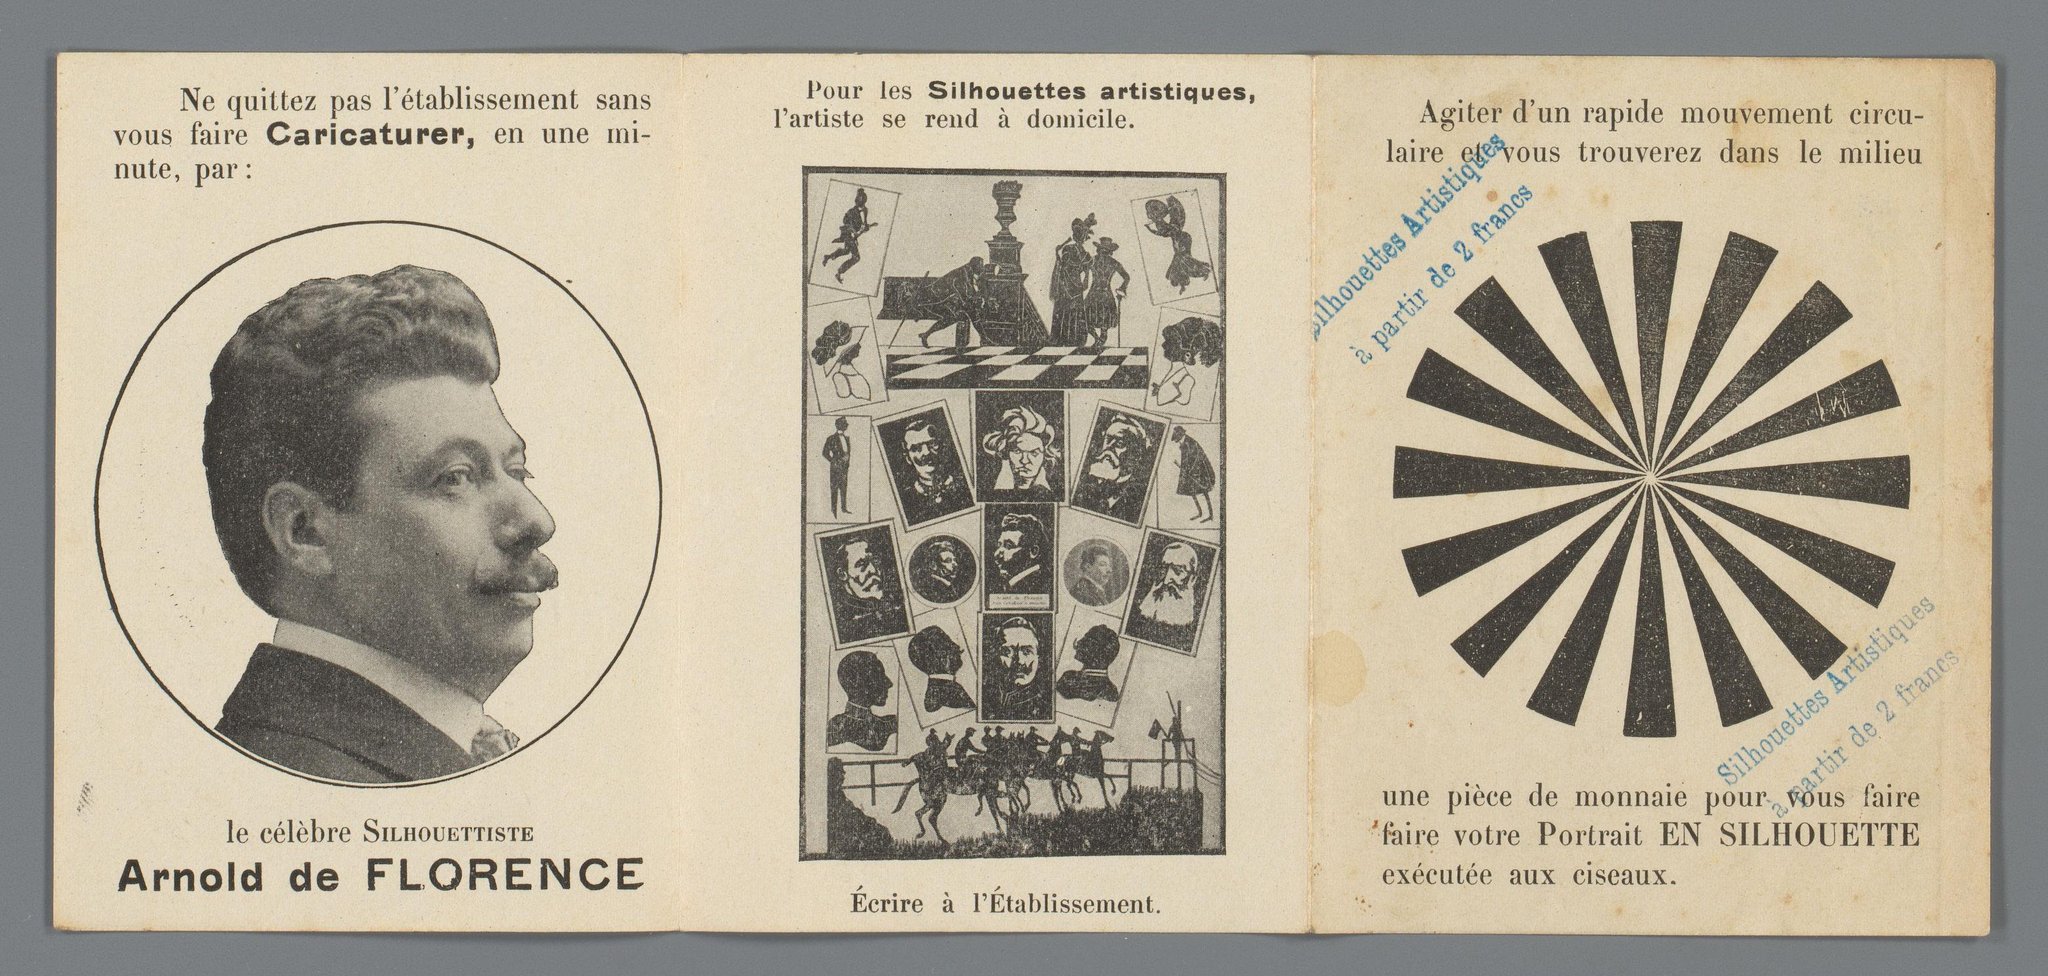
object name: photomechanical print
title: Reclamefolder voor 'le célèbre Silhouettiste Arnold de Florence'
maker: Anonymous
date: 1875-1925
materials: paper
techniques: autotype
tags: advertising, portrait, self-portrait of draughtsman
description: Reclamefolder voor het laten maken van een silhouet karikatuur door Arnold de Florence.